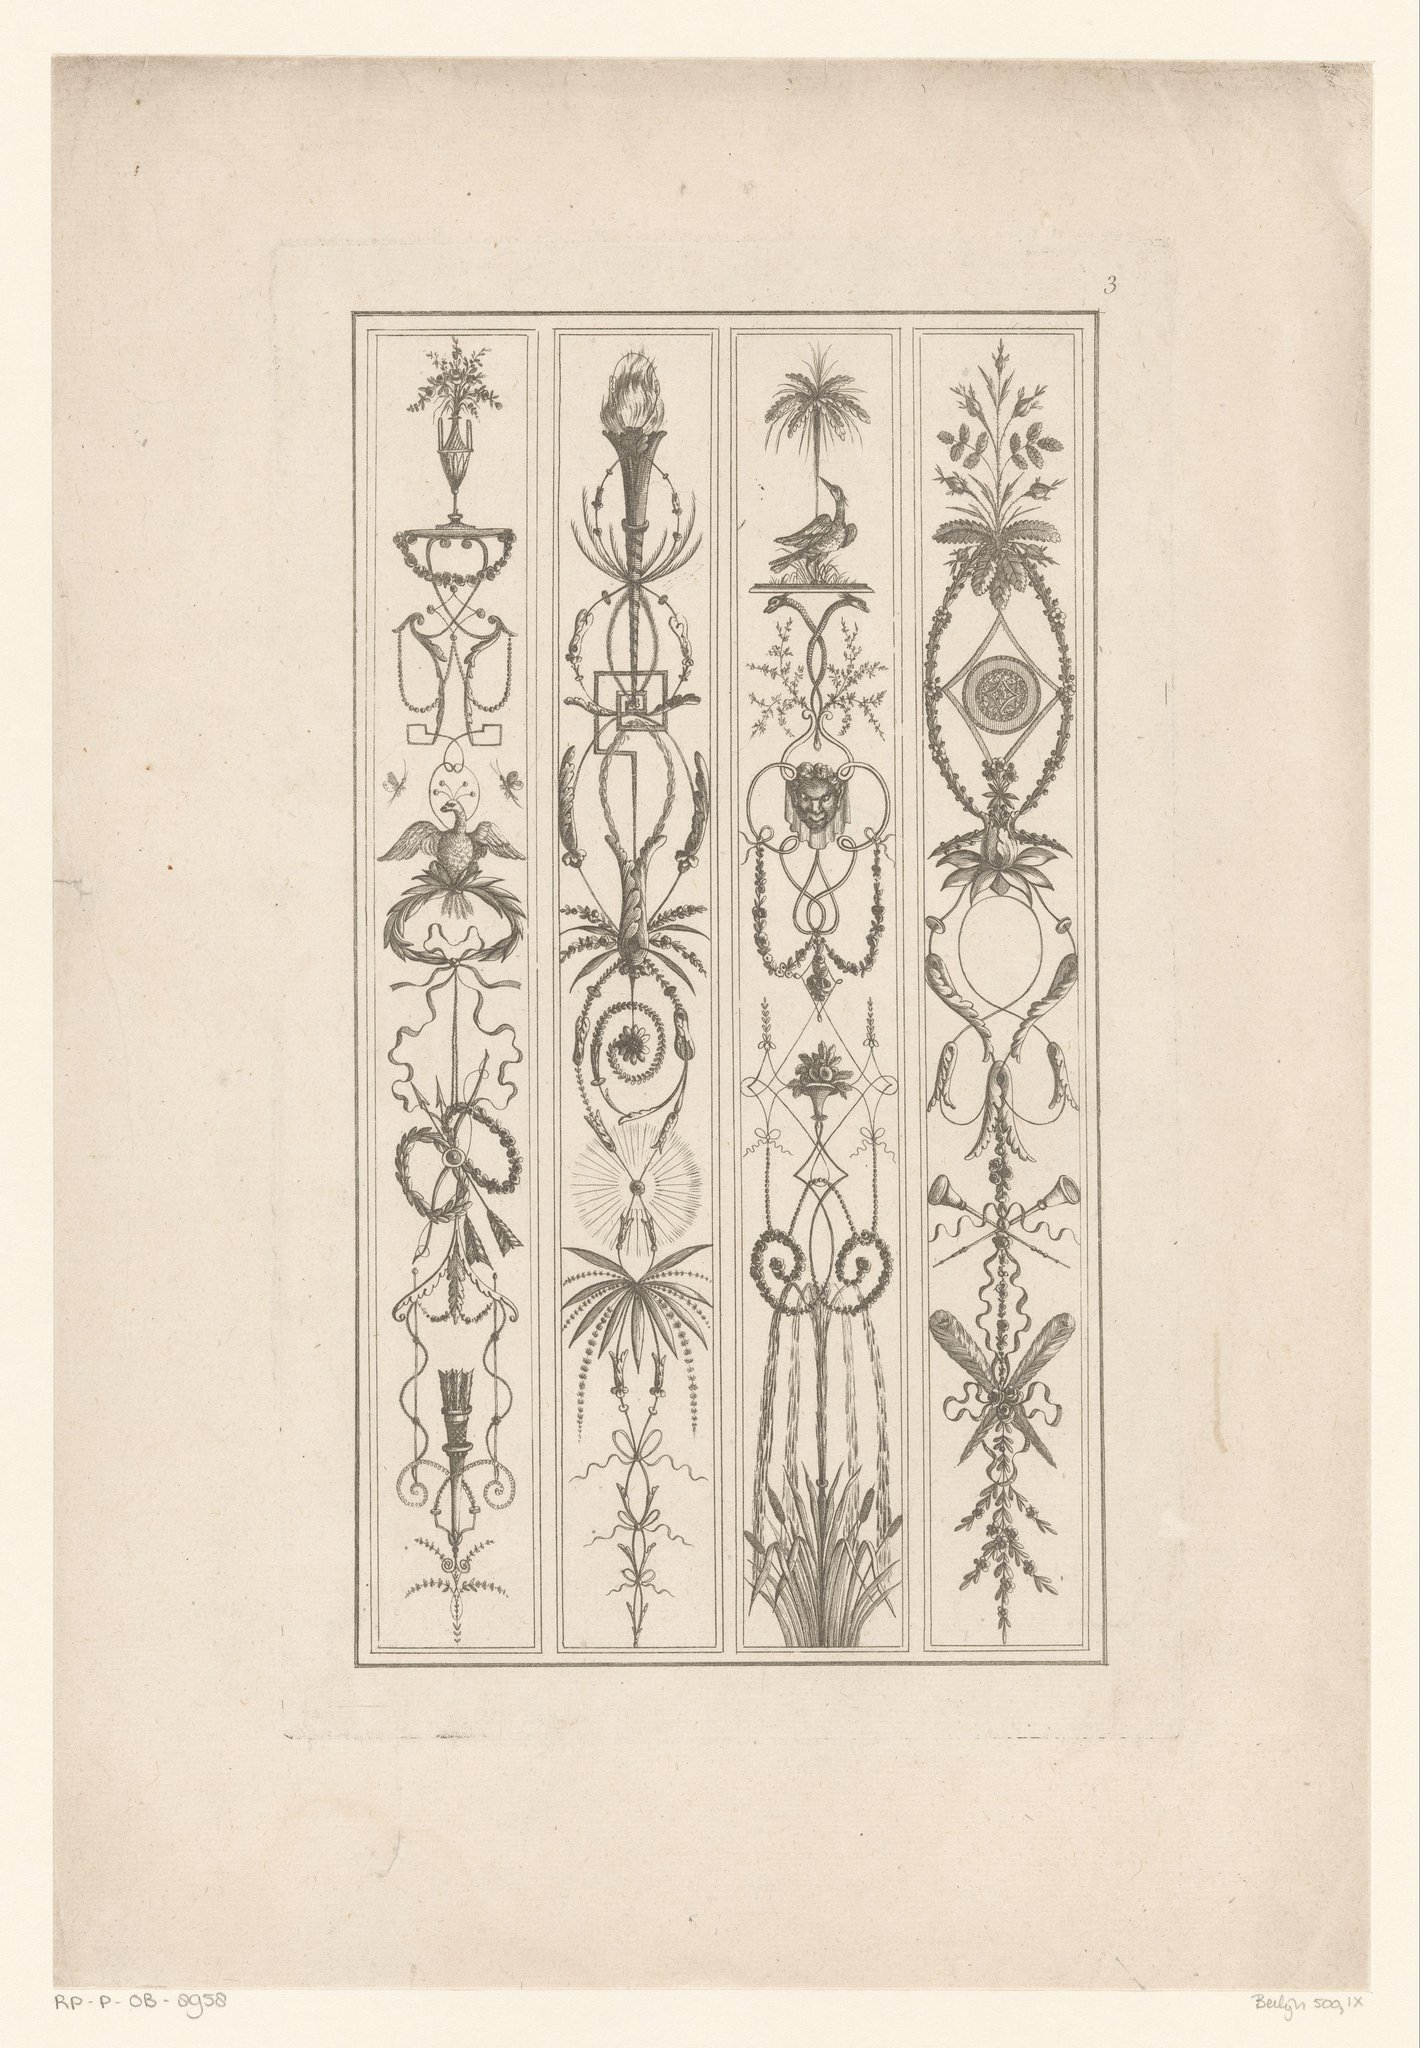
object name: print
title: IXe Cahier d'Arabesques et Bordures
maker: jean baptiste fay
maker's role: print maker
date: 1784-1796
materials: paper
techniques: engraving, etching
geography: paris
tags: torch, ornament ~ arabesque, birds, ornamental fountain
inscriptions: collector's mark: Lugt 2228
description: Vier verticale panelen met arabesken en een vogel (vermoedelijk een pauw), pijlen, pijlenkoker, een fakkel, een masker, een fontein, lisdodden en veren.